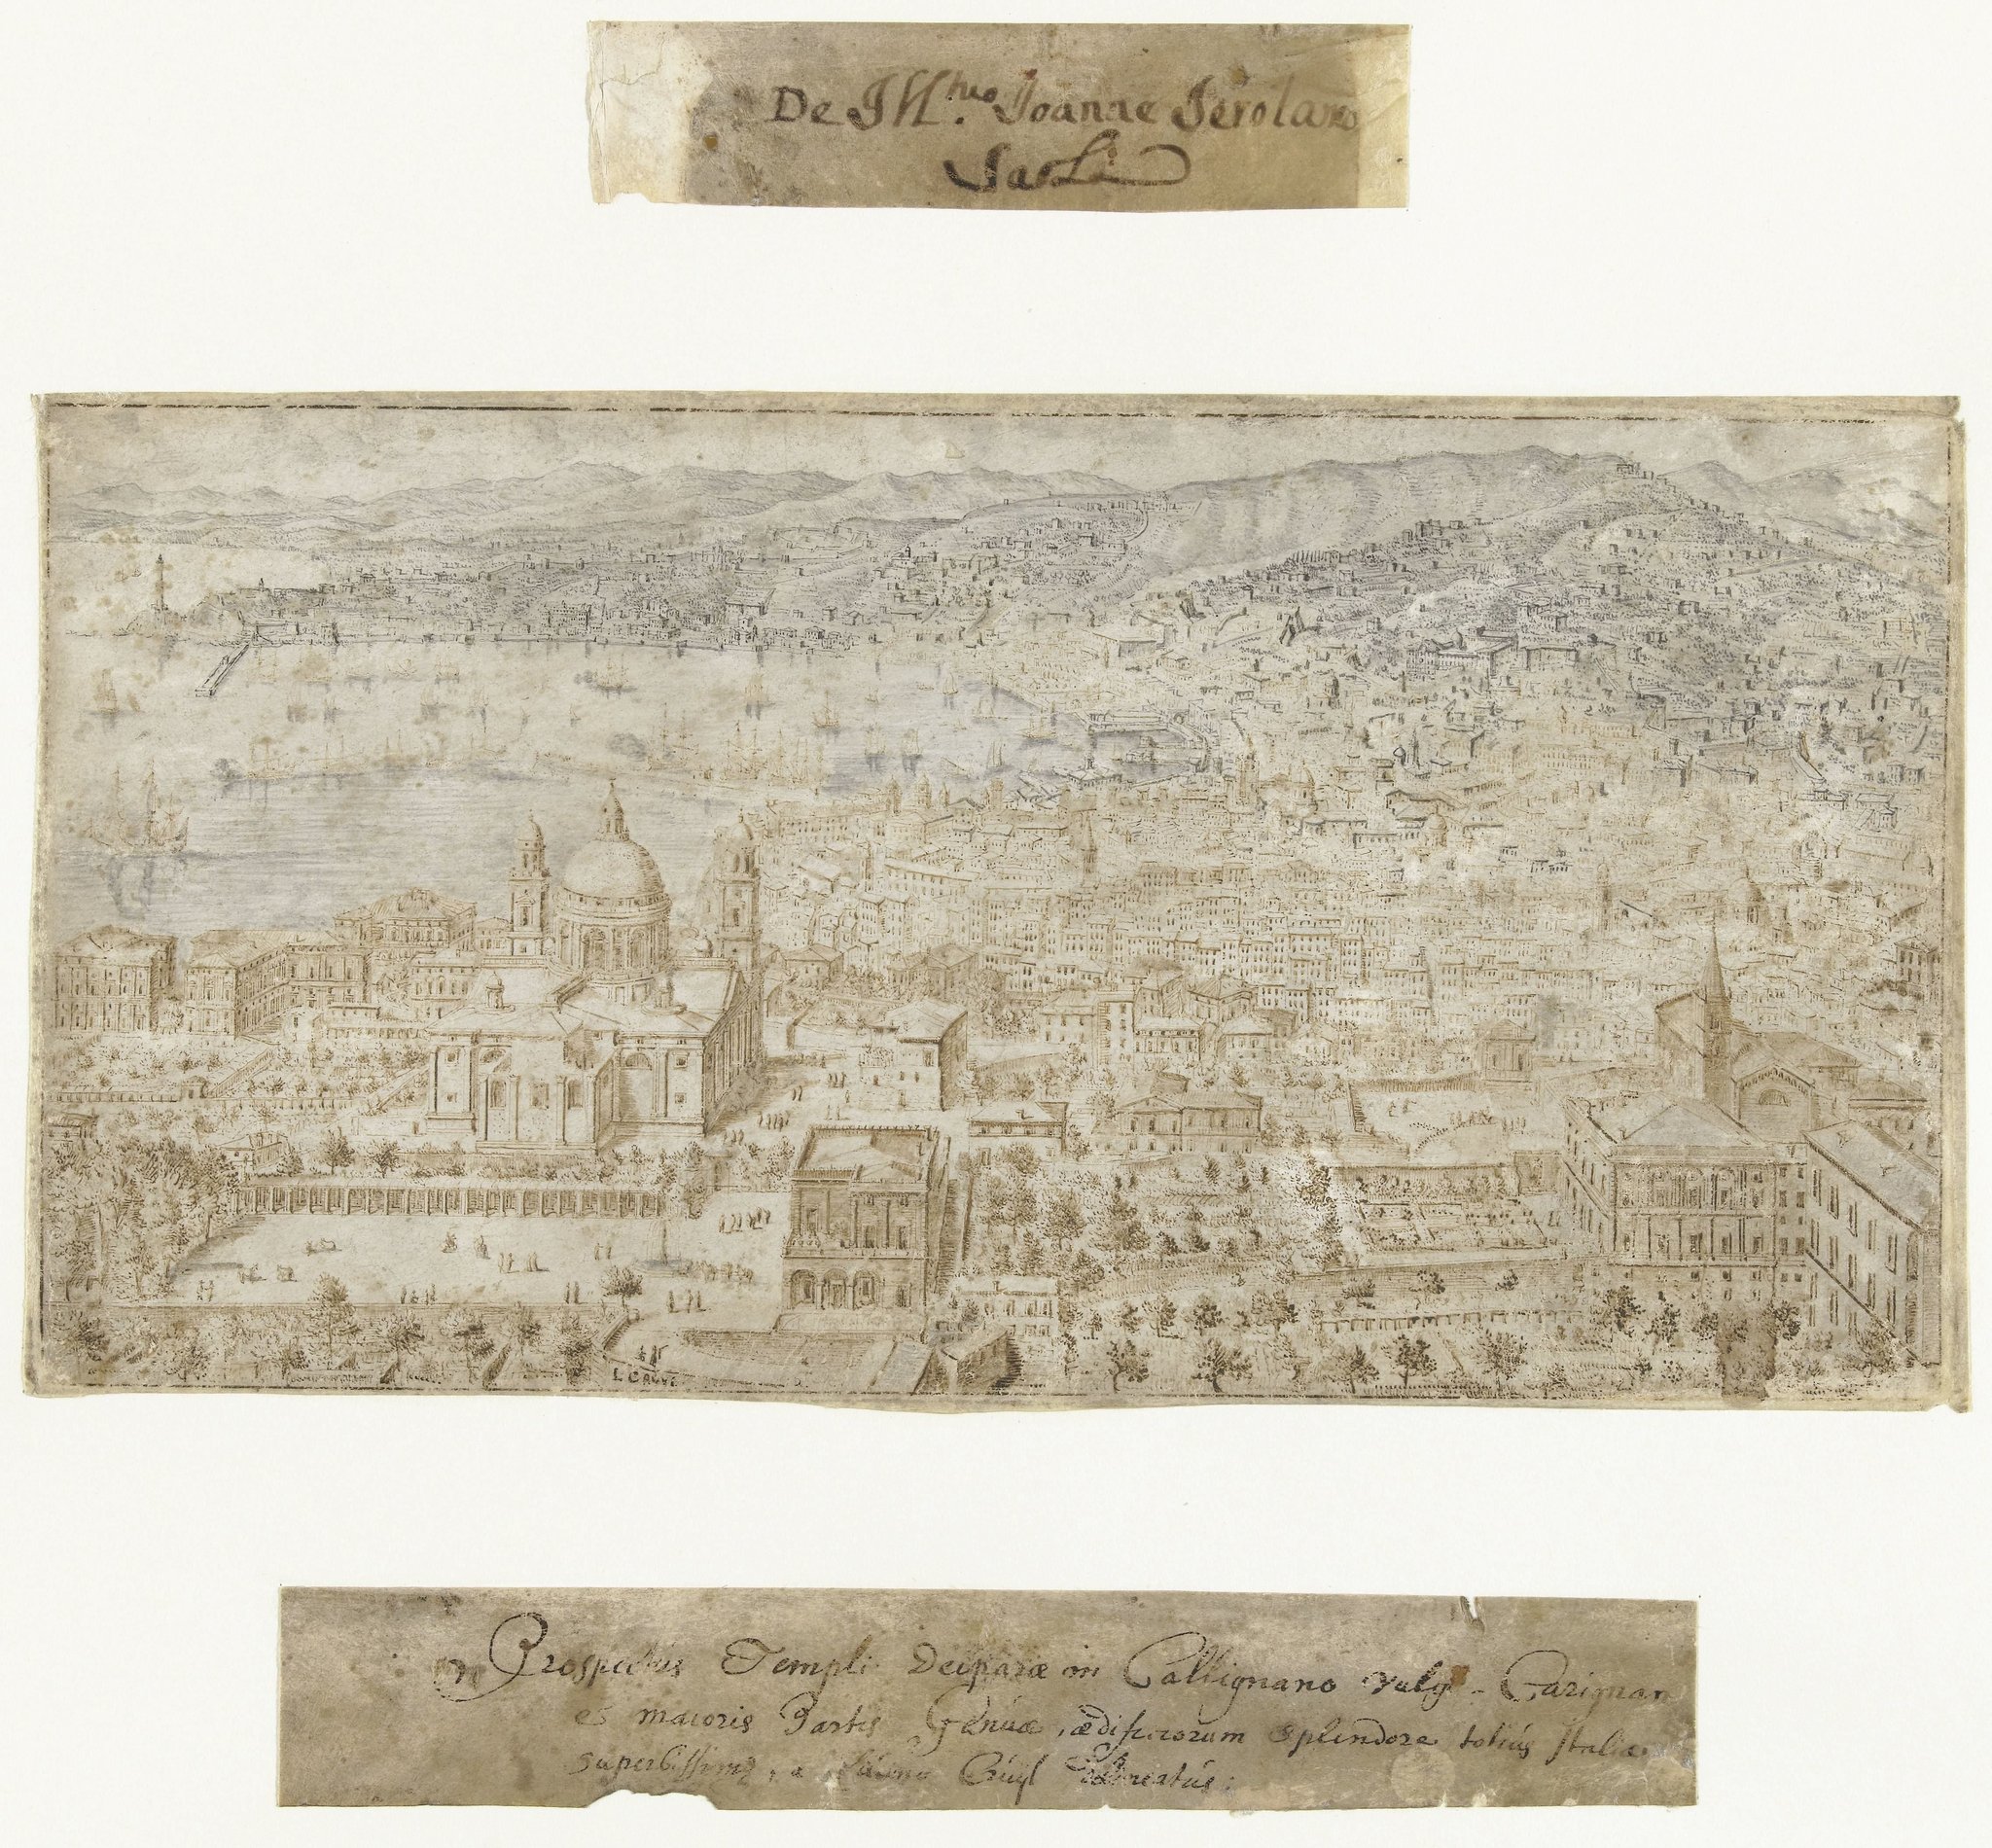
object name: drawing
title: Gezicht op Genua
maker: lievin cruyl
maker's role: draughtsman, print maker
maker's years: 1634-1720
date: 1650-1720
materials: ink, parchment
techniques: brush, pen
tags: prospect of city, town panorama, silhouette of city, italy